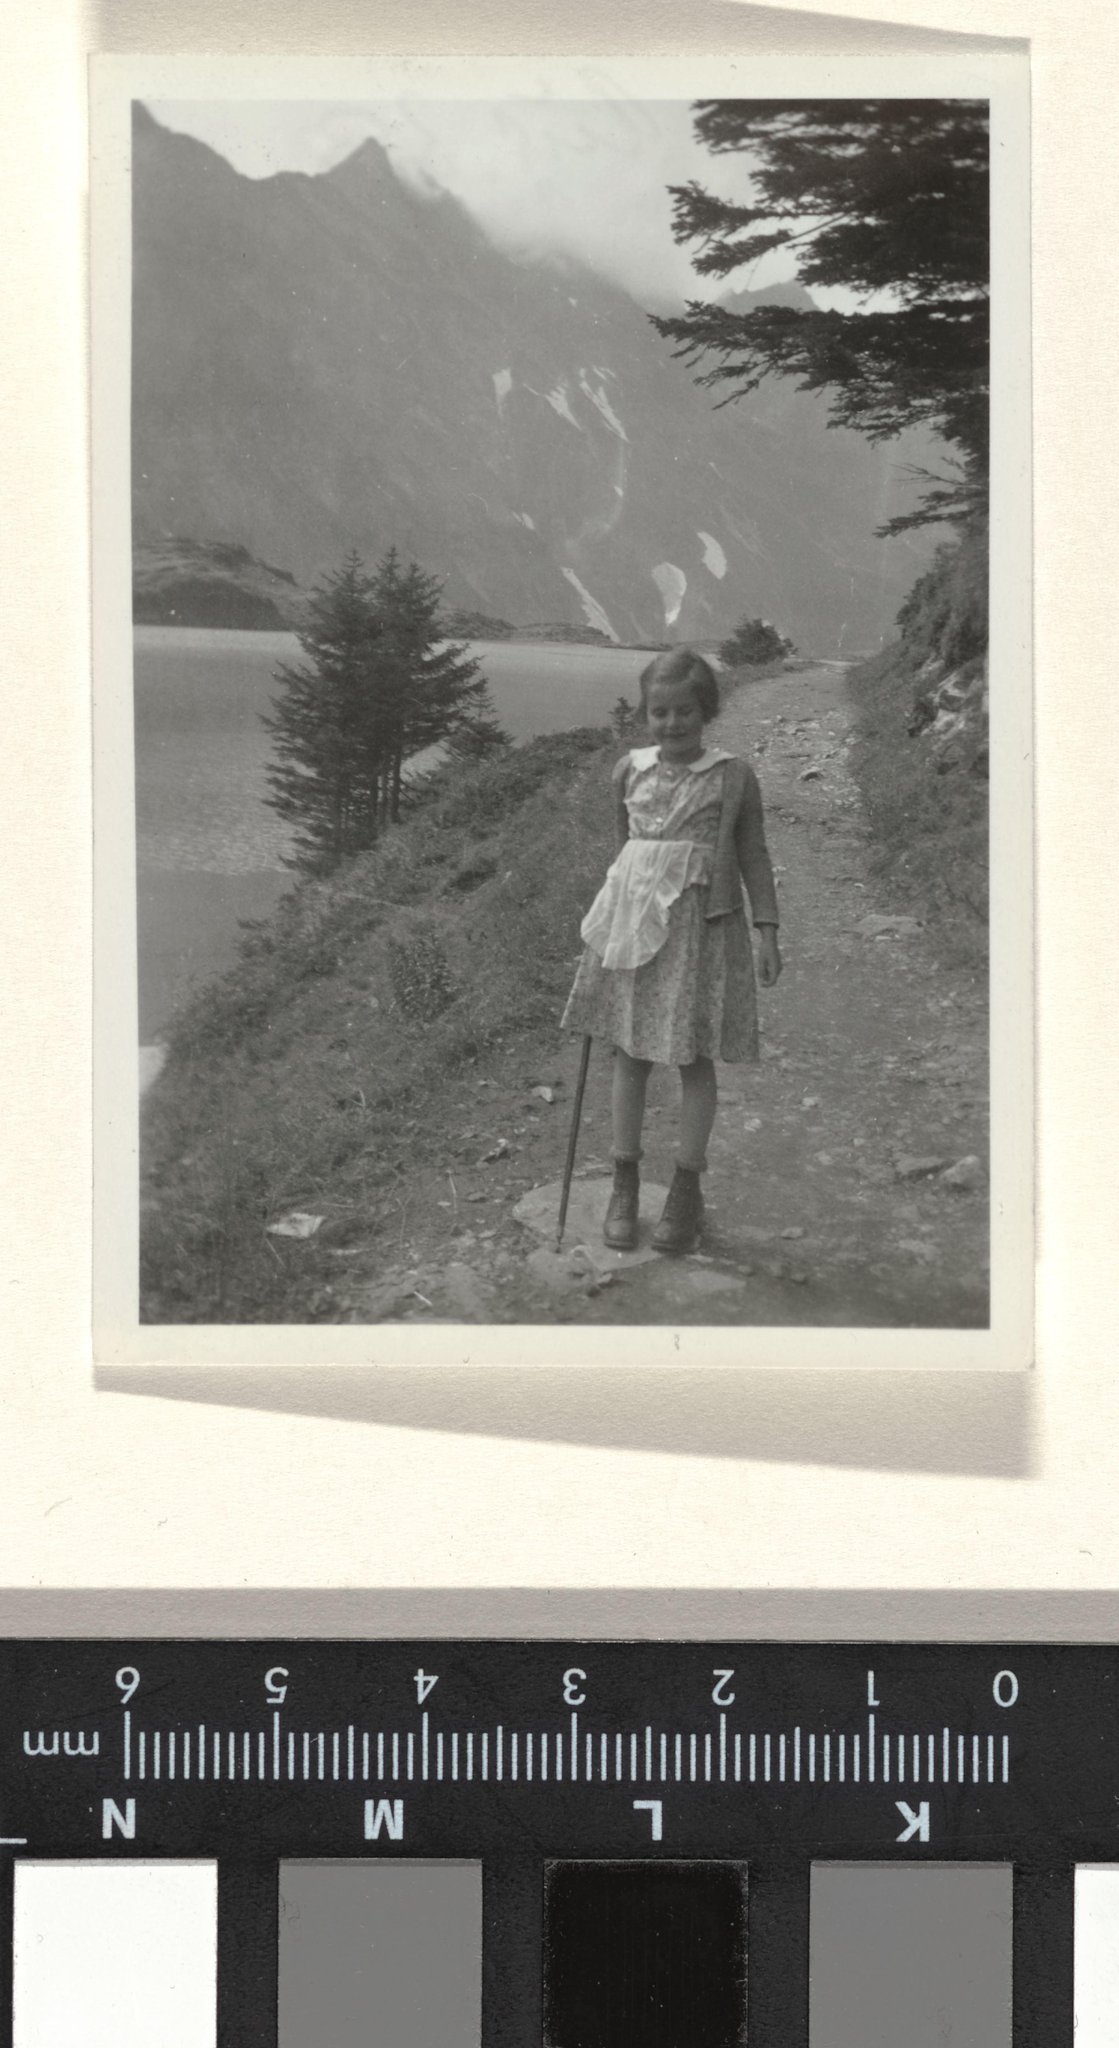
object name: photograph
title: Isabel Wachenheimer met schort en jurk op een bergweg bij de Trübsee, in augustus 1935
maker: Anonymous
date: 1908-1935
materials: photographic support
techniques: gelatin silver print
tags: leiden, isabel wachenheimer-elon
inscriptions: date: ‘Aug.35. 93’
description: Isabel Wachenheimer met schort en jurk op een bergweg bij de Trübsee.